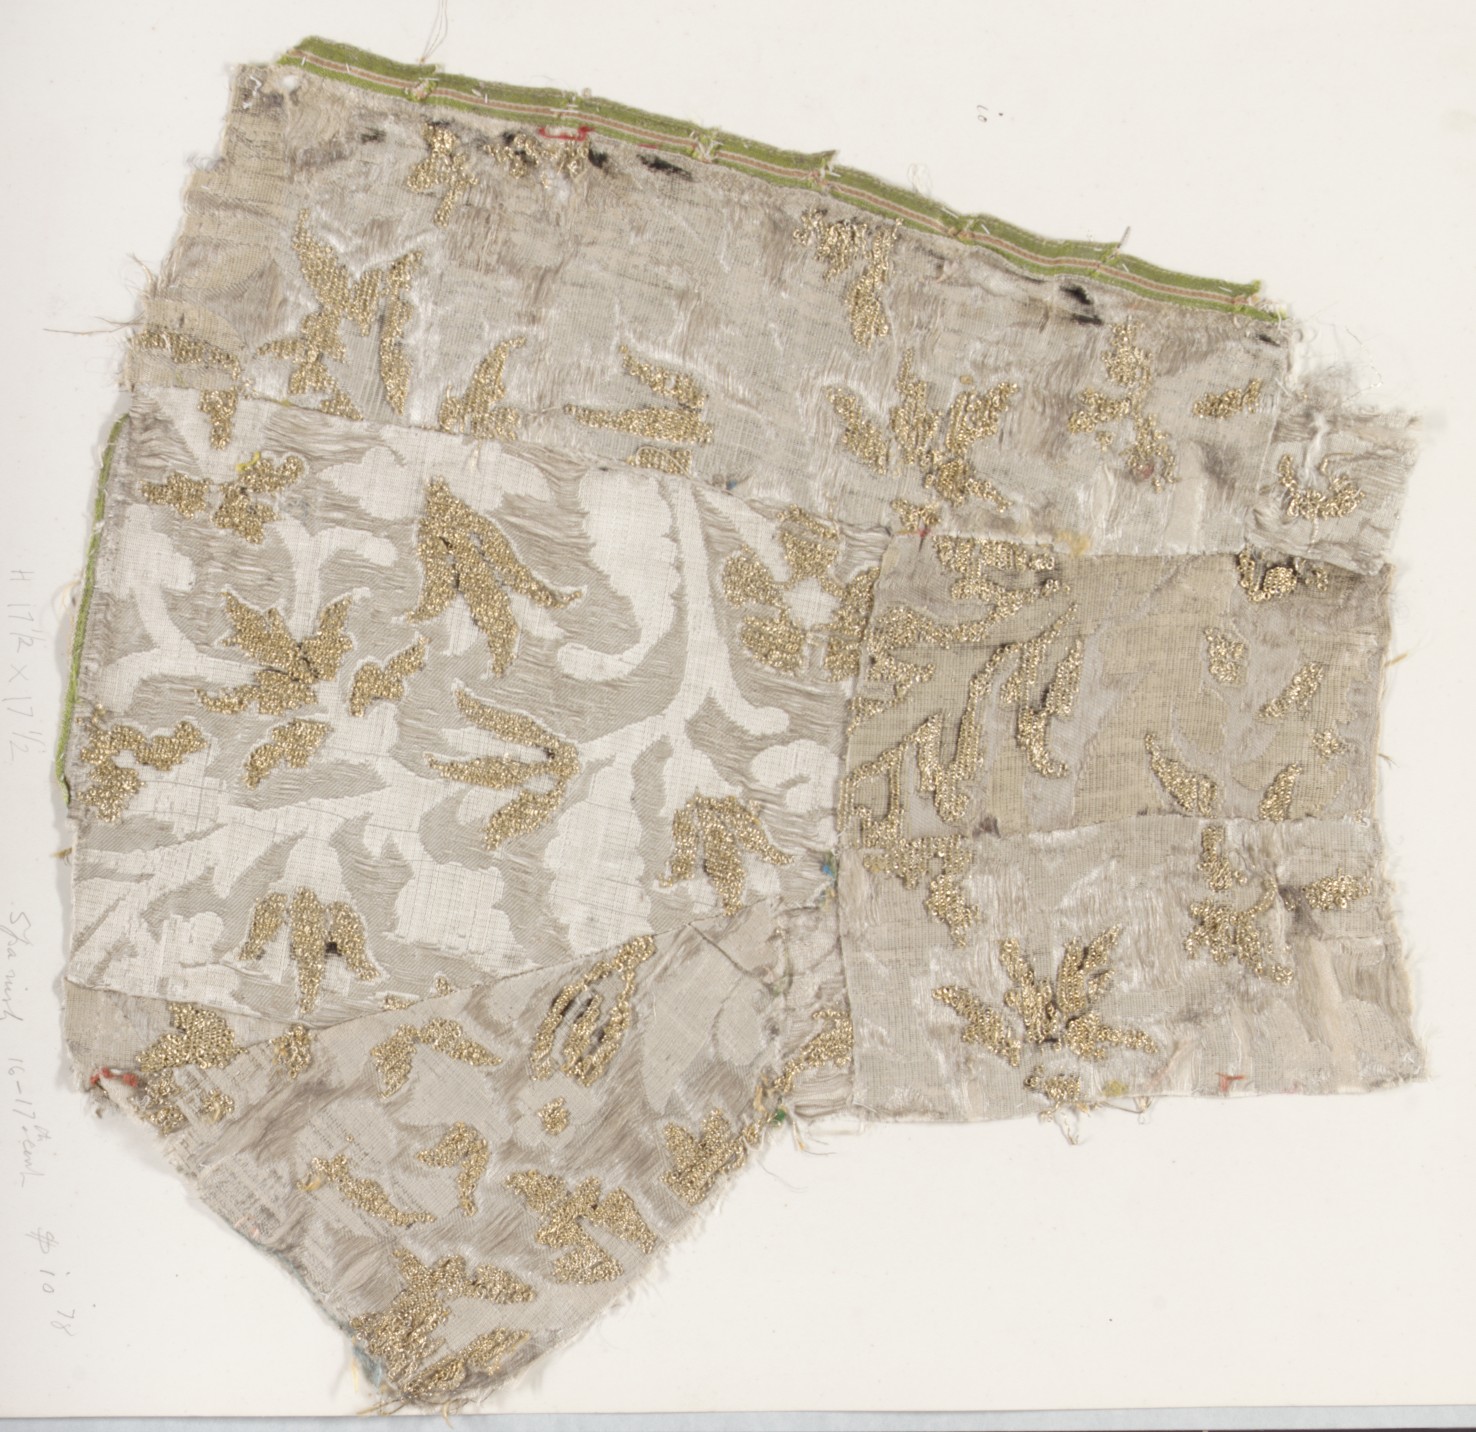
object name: fragment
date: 1501-1700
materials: metal thread, silk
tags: flowers,leaves